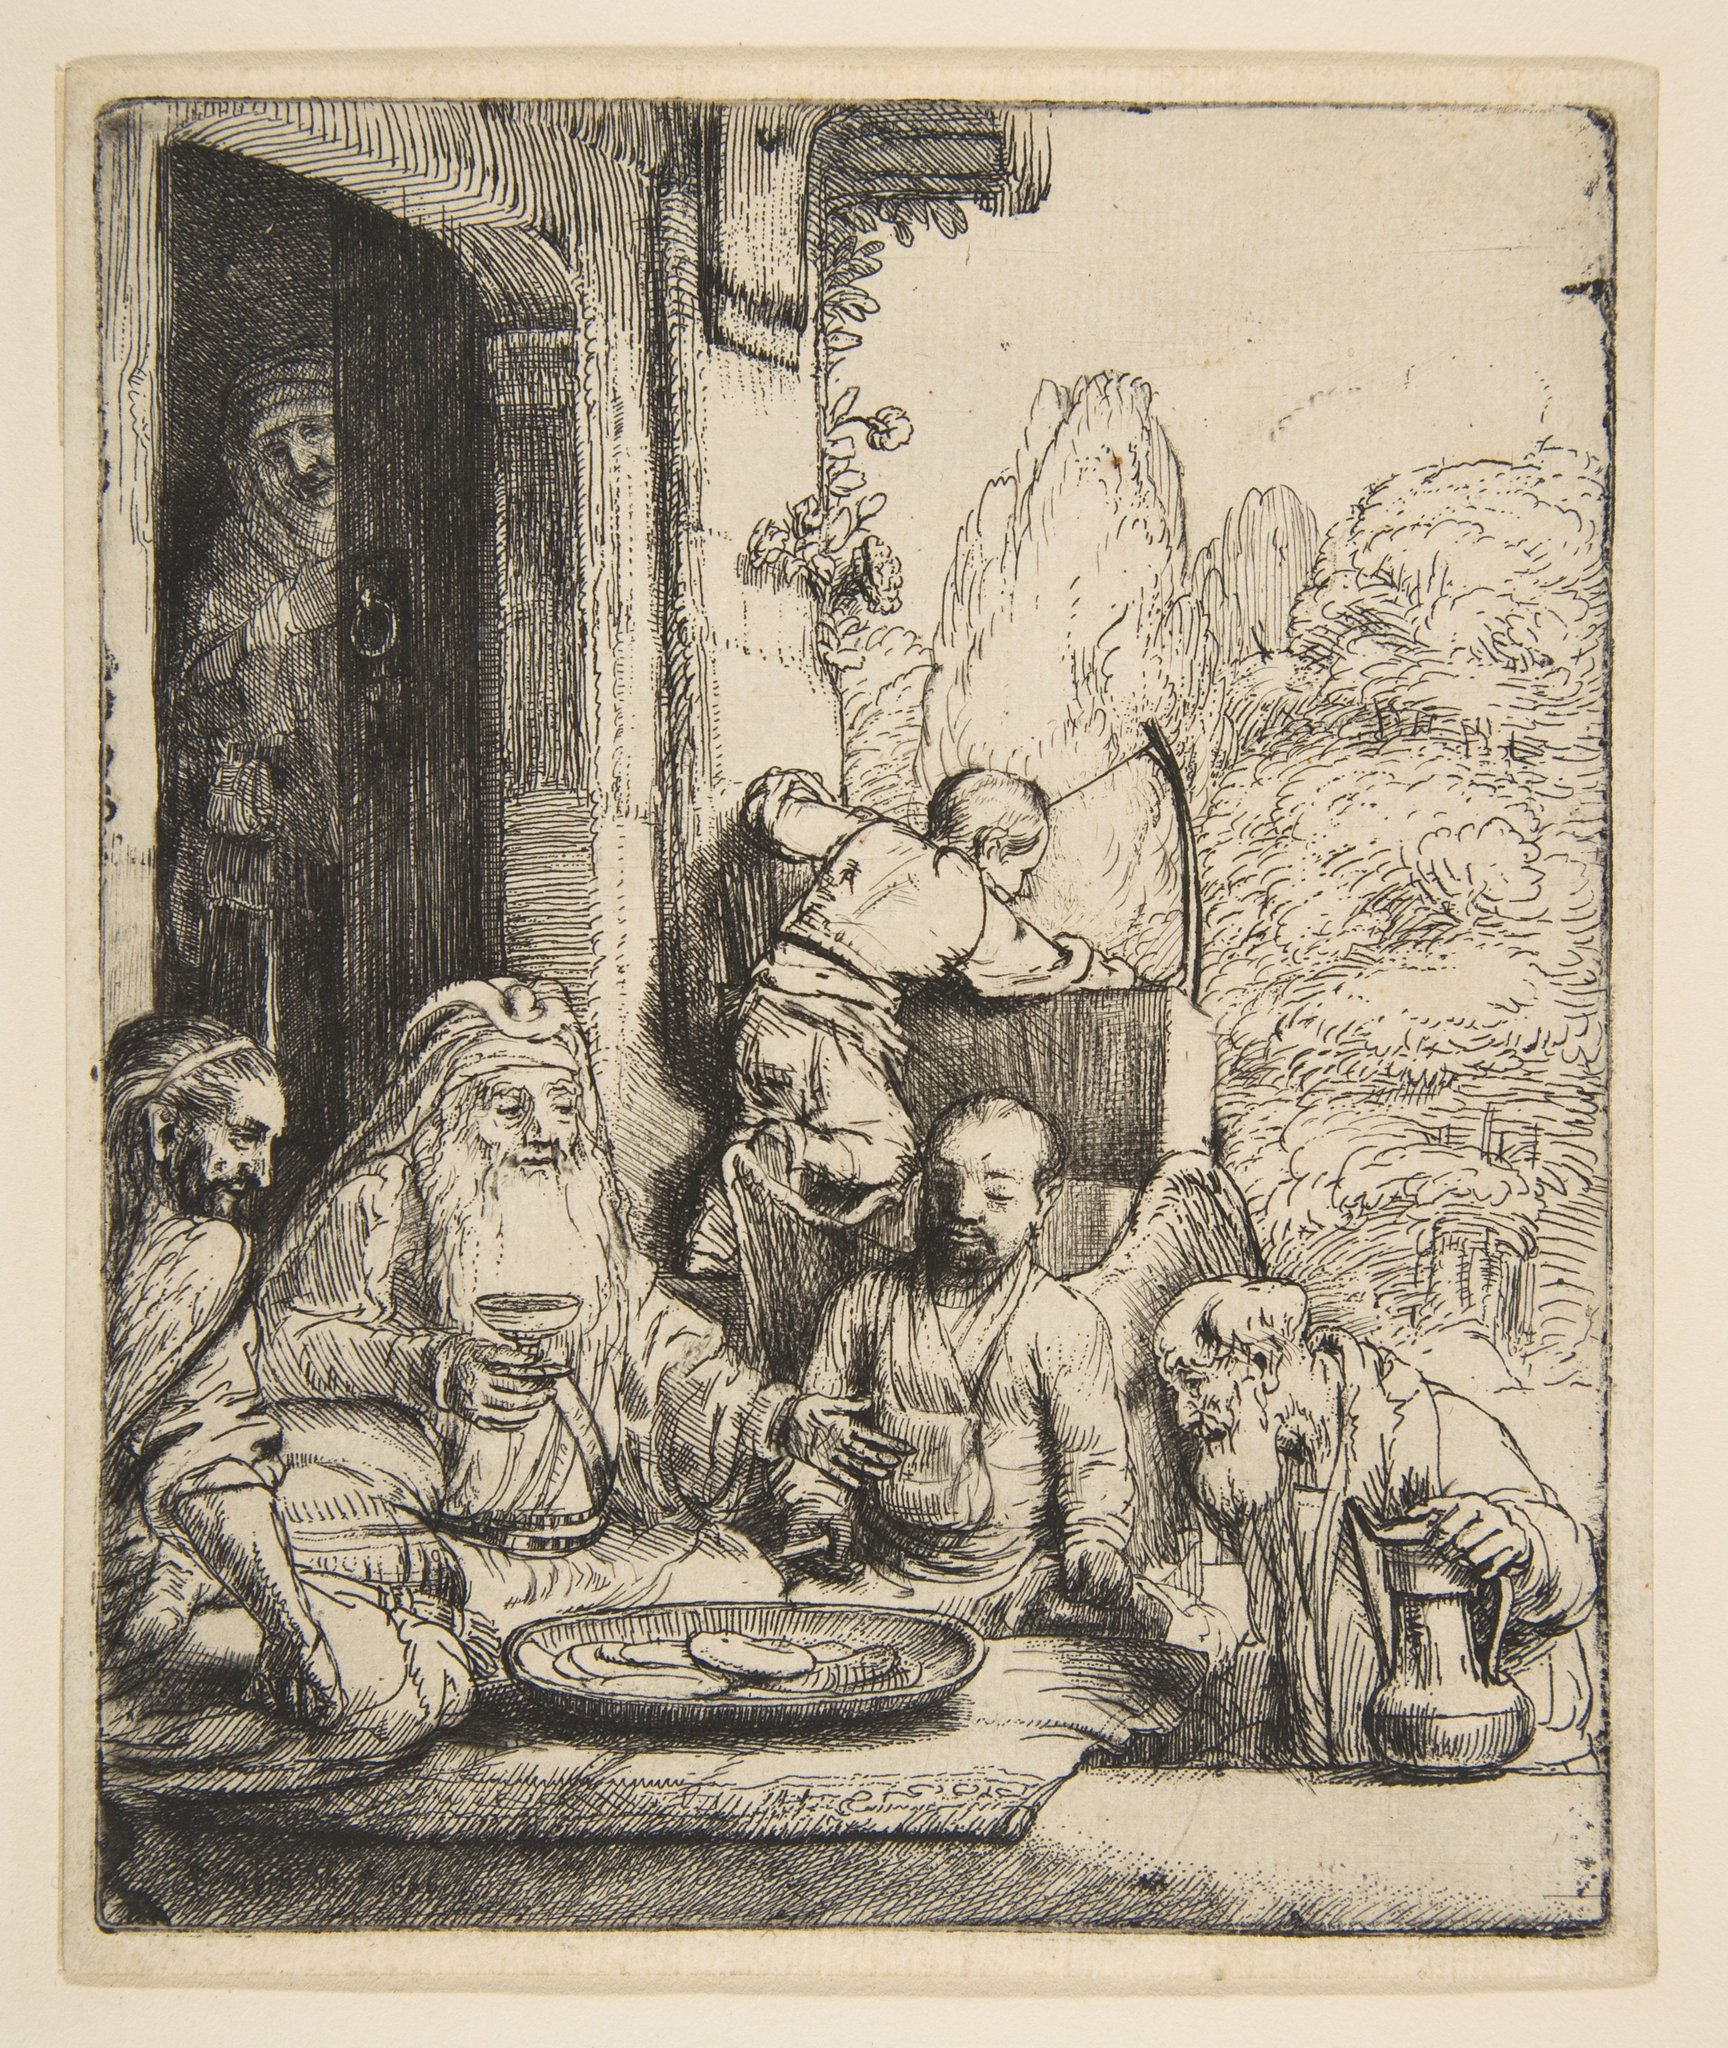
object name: print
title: Abraham Entertaining the Angels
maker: rembrandt van rijn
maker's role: artist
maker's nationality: dutch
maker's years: 1606-1669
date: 1656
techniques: drypoint, etching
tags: doors,men,angels,abraham